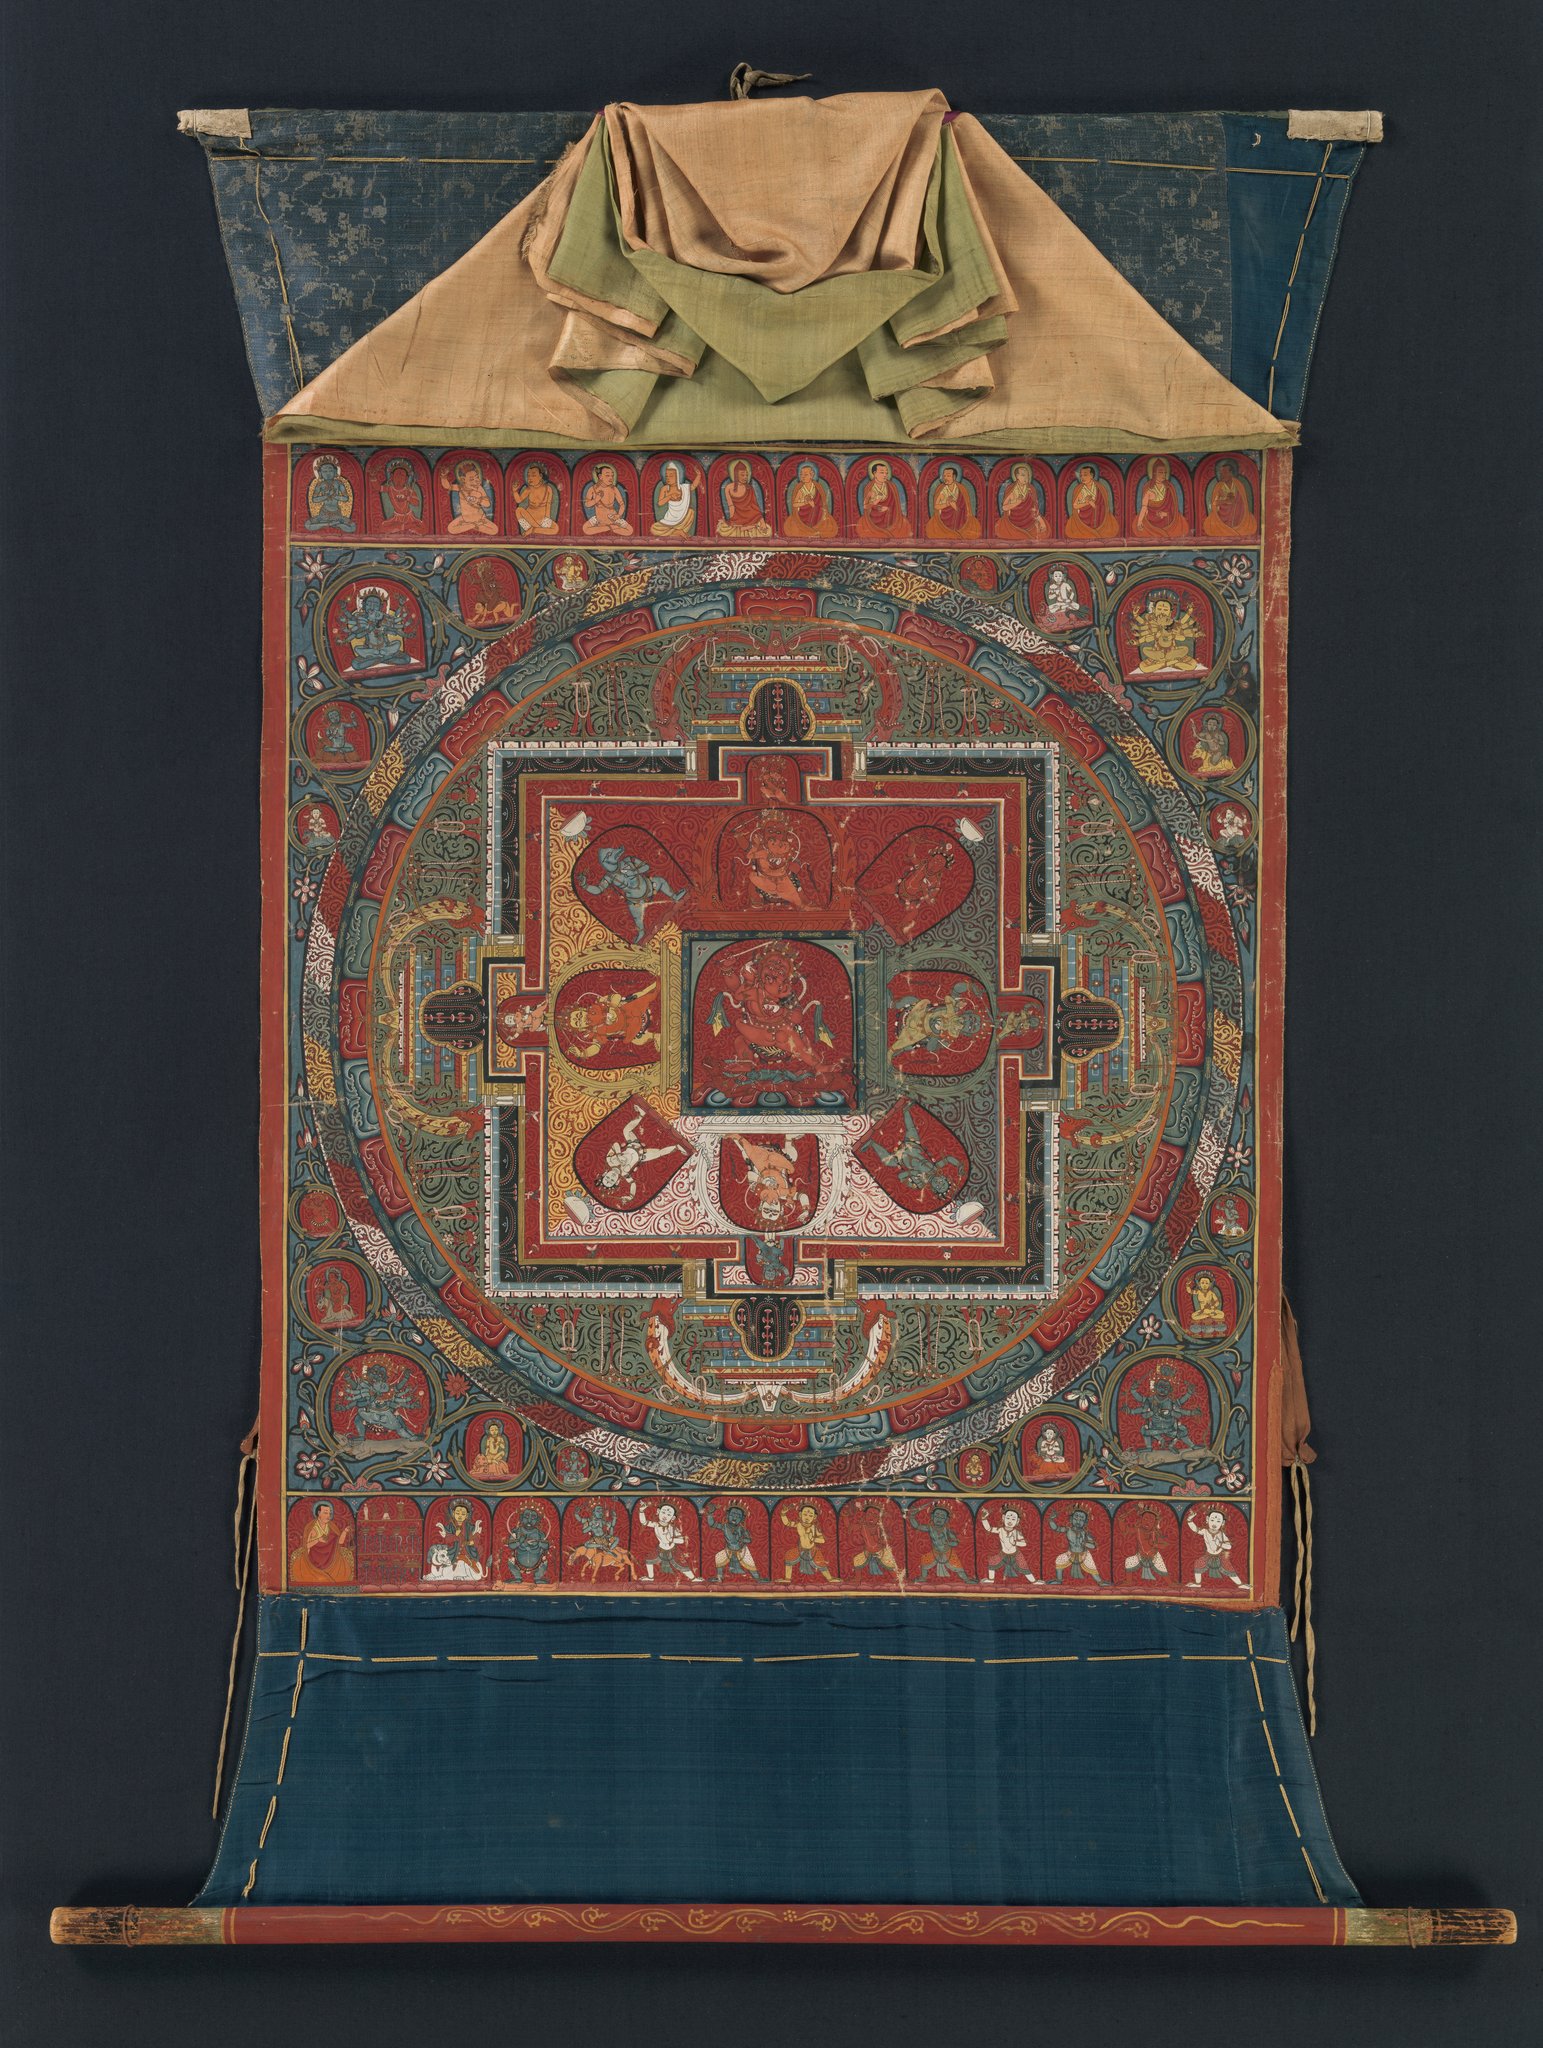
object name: thangka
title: Mandala of Raktayamari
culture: tibetan, central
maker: mikyo dorje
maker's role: artist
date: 1367-1400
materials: textile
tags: couples,buddhism,deities,monks